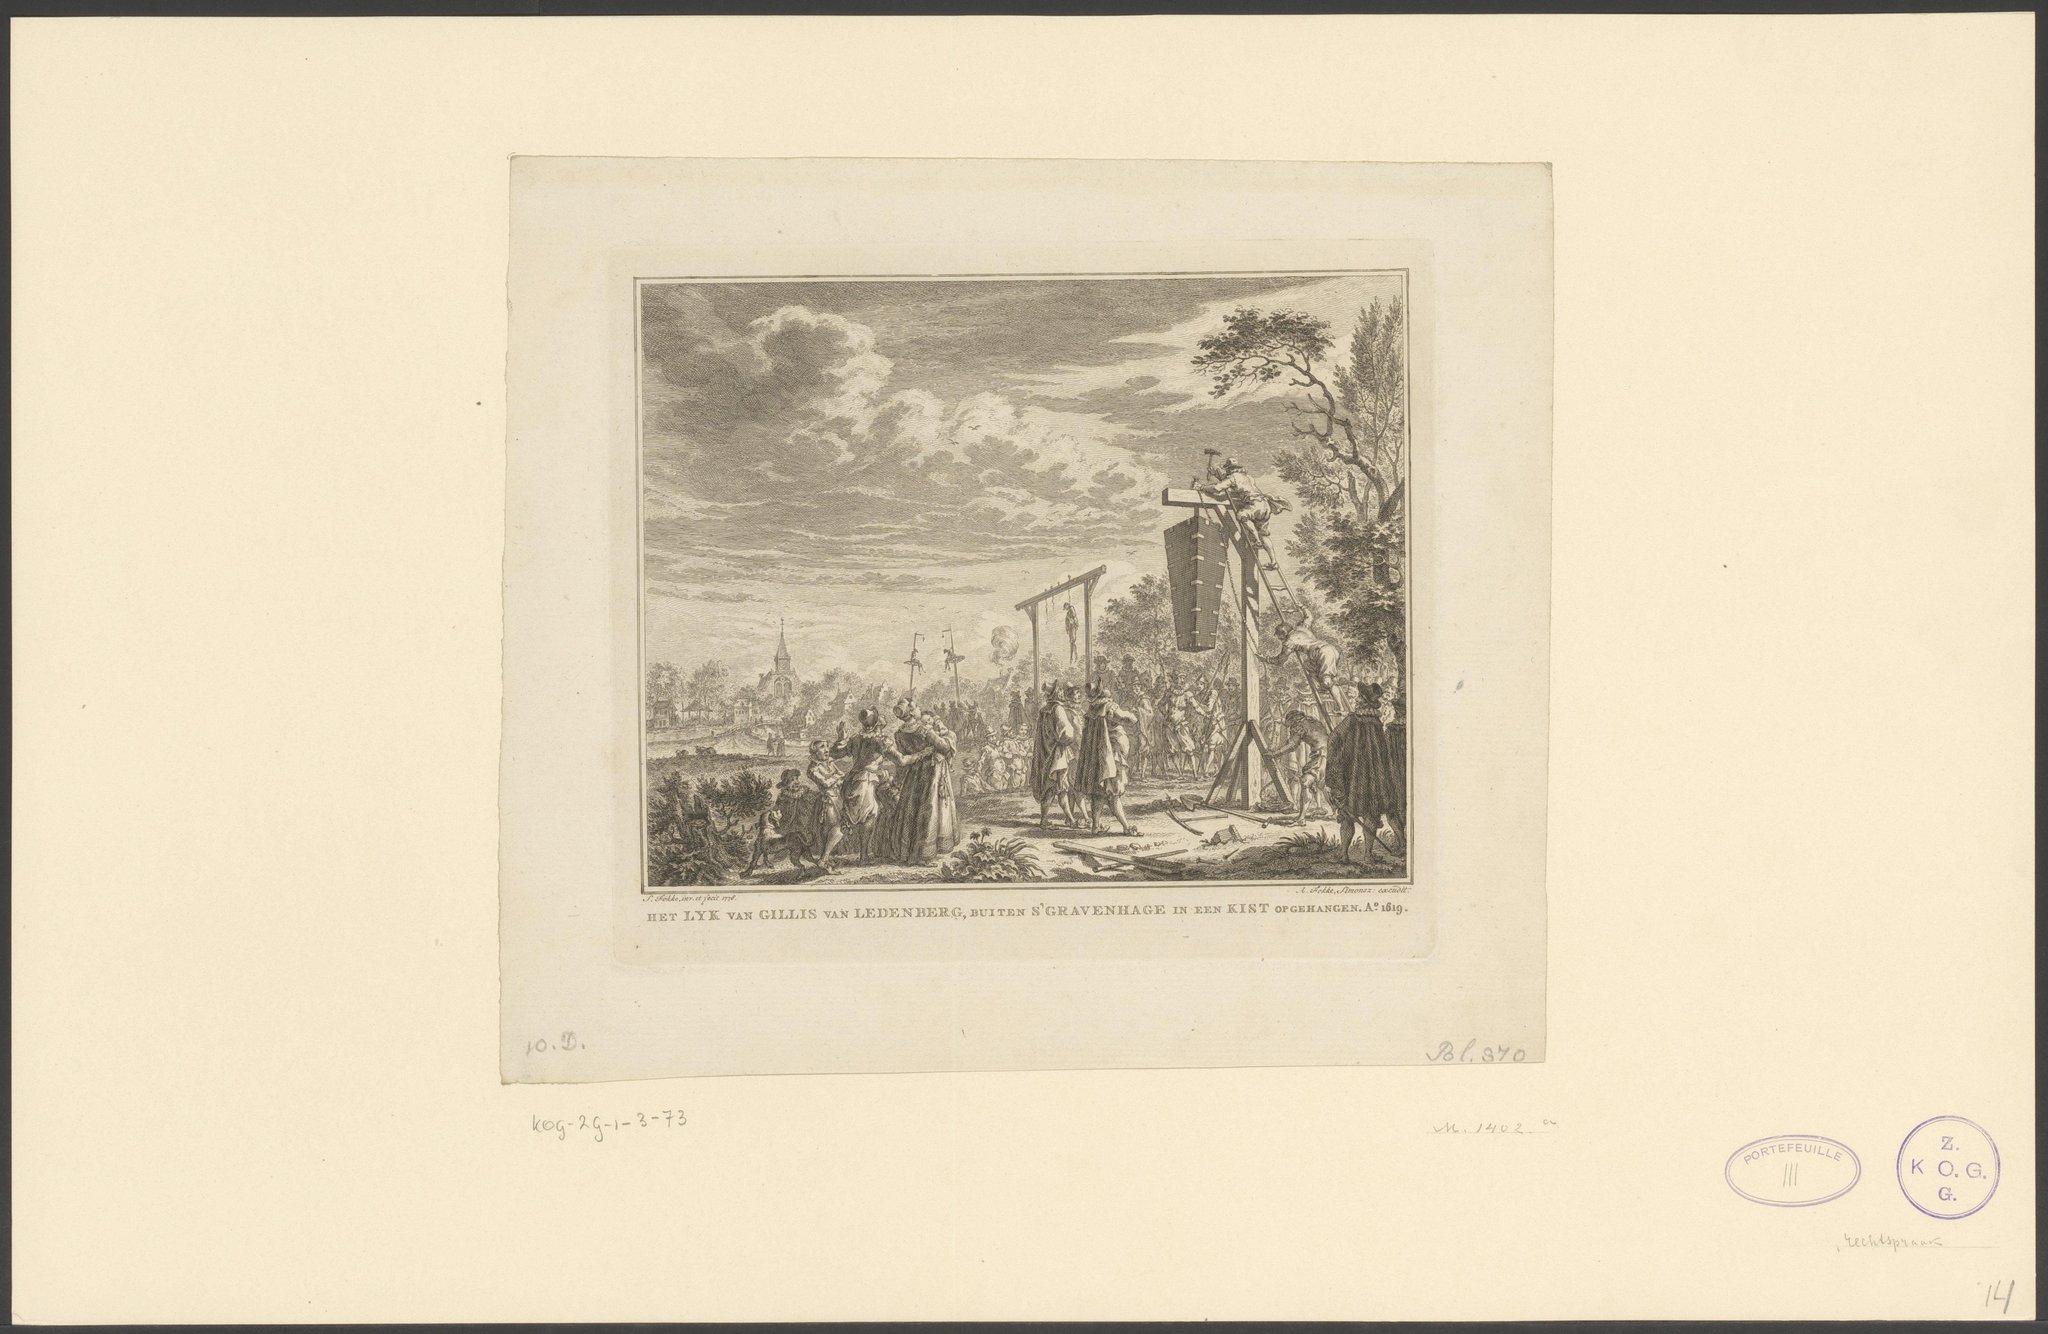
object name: print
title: Het lyk van Gillis van Ledenberg, buiten s'Gravenhage in een kist opgehangen. Ao. 1619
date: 1776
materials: paper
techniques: engraving, etching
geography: amsterdam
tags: utrecht, violent death by hanging, seeking death, suicide, the hague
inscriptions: collector's mark: Lugt 1641, stamp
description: De kist met de overblijfselen van Gilles van Ledenberg aan de galg wordt gehangen, buiten Den Haag, 15 mei 1619. Onderwerpsrubrieken binnen de Atlas Zeden en Gewoonten: Regeering, Rechtswezen.